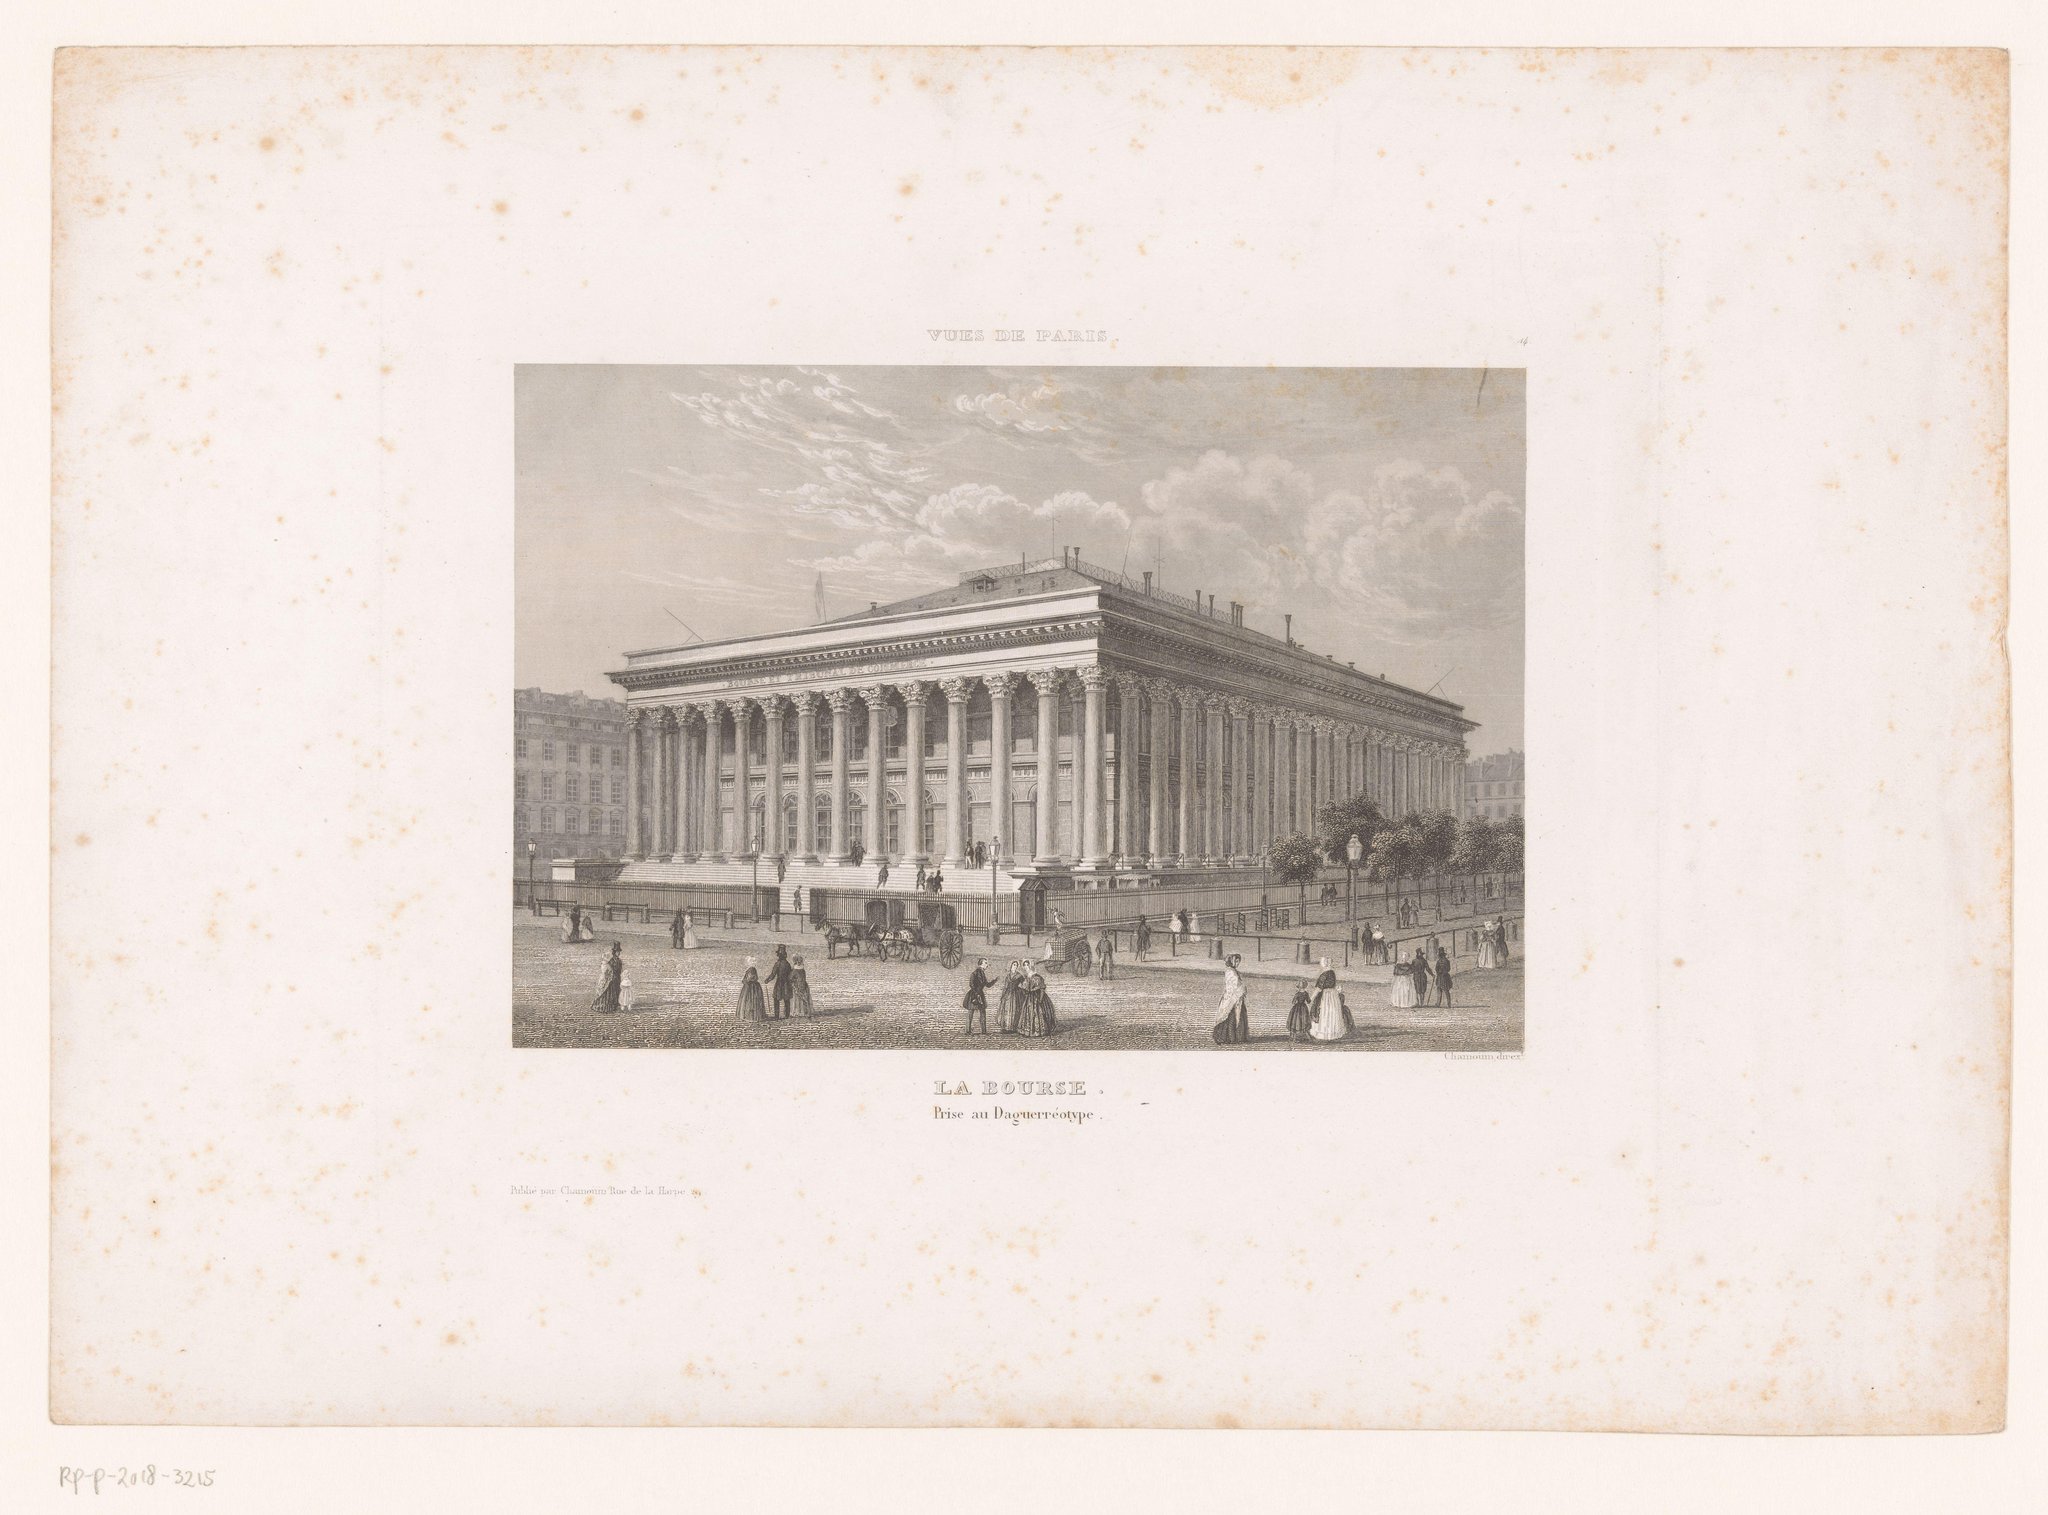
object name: print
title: La Bourse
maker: alphonse chamouin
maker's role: print maker, publisher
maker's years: 1800-1870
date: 1850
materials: paper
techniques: engraving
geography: paris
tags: stock exchange, stock-market, paris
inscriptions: collector's mark: Lugt 2228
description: Prent maakt deel uit van een serie van 28 prenten over Parijs naar daguerreotypieën.